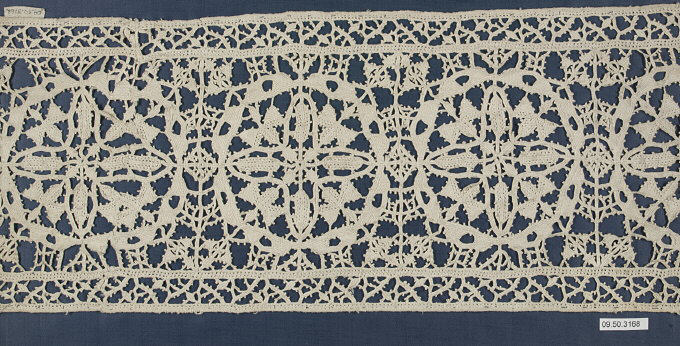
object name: strip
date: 1601-1700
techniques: lace